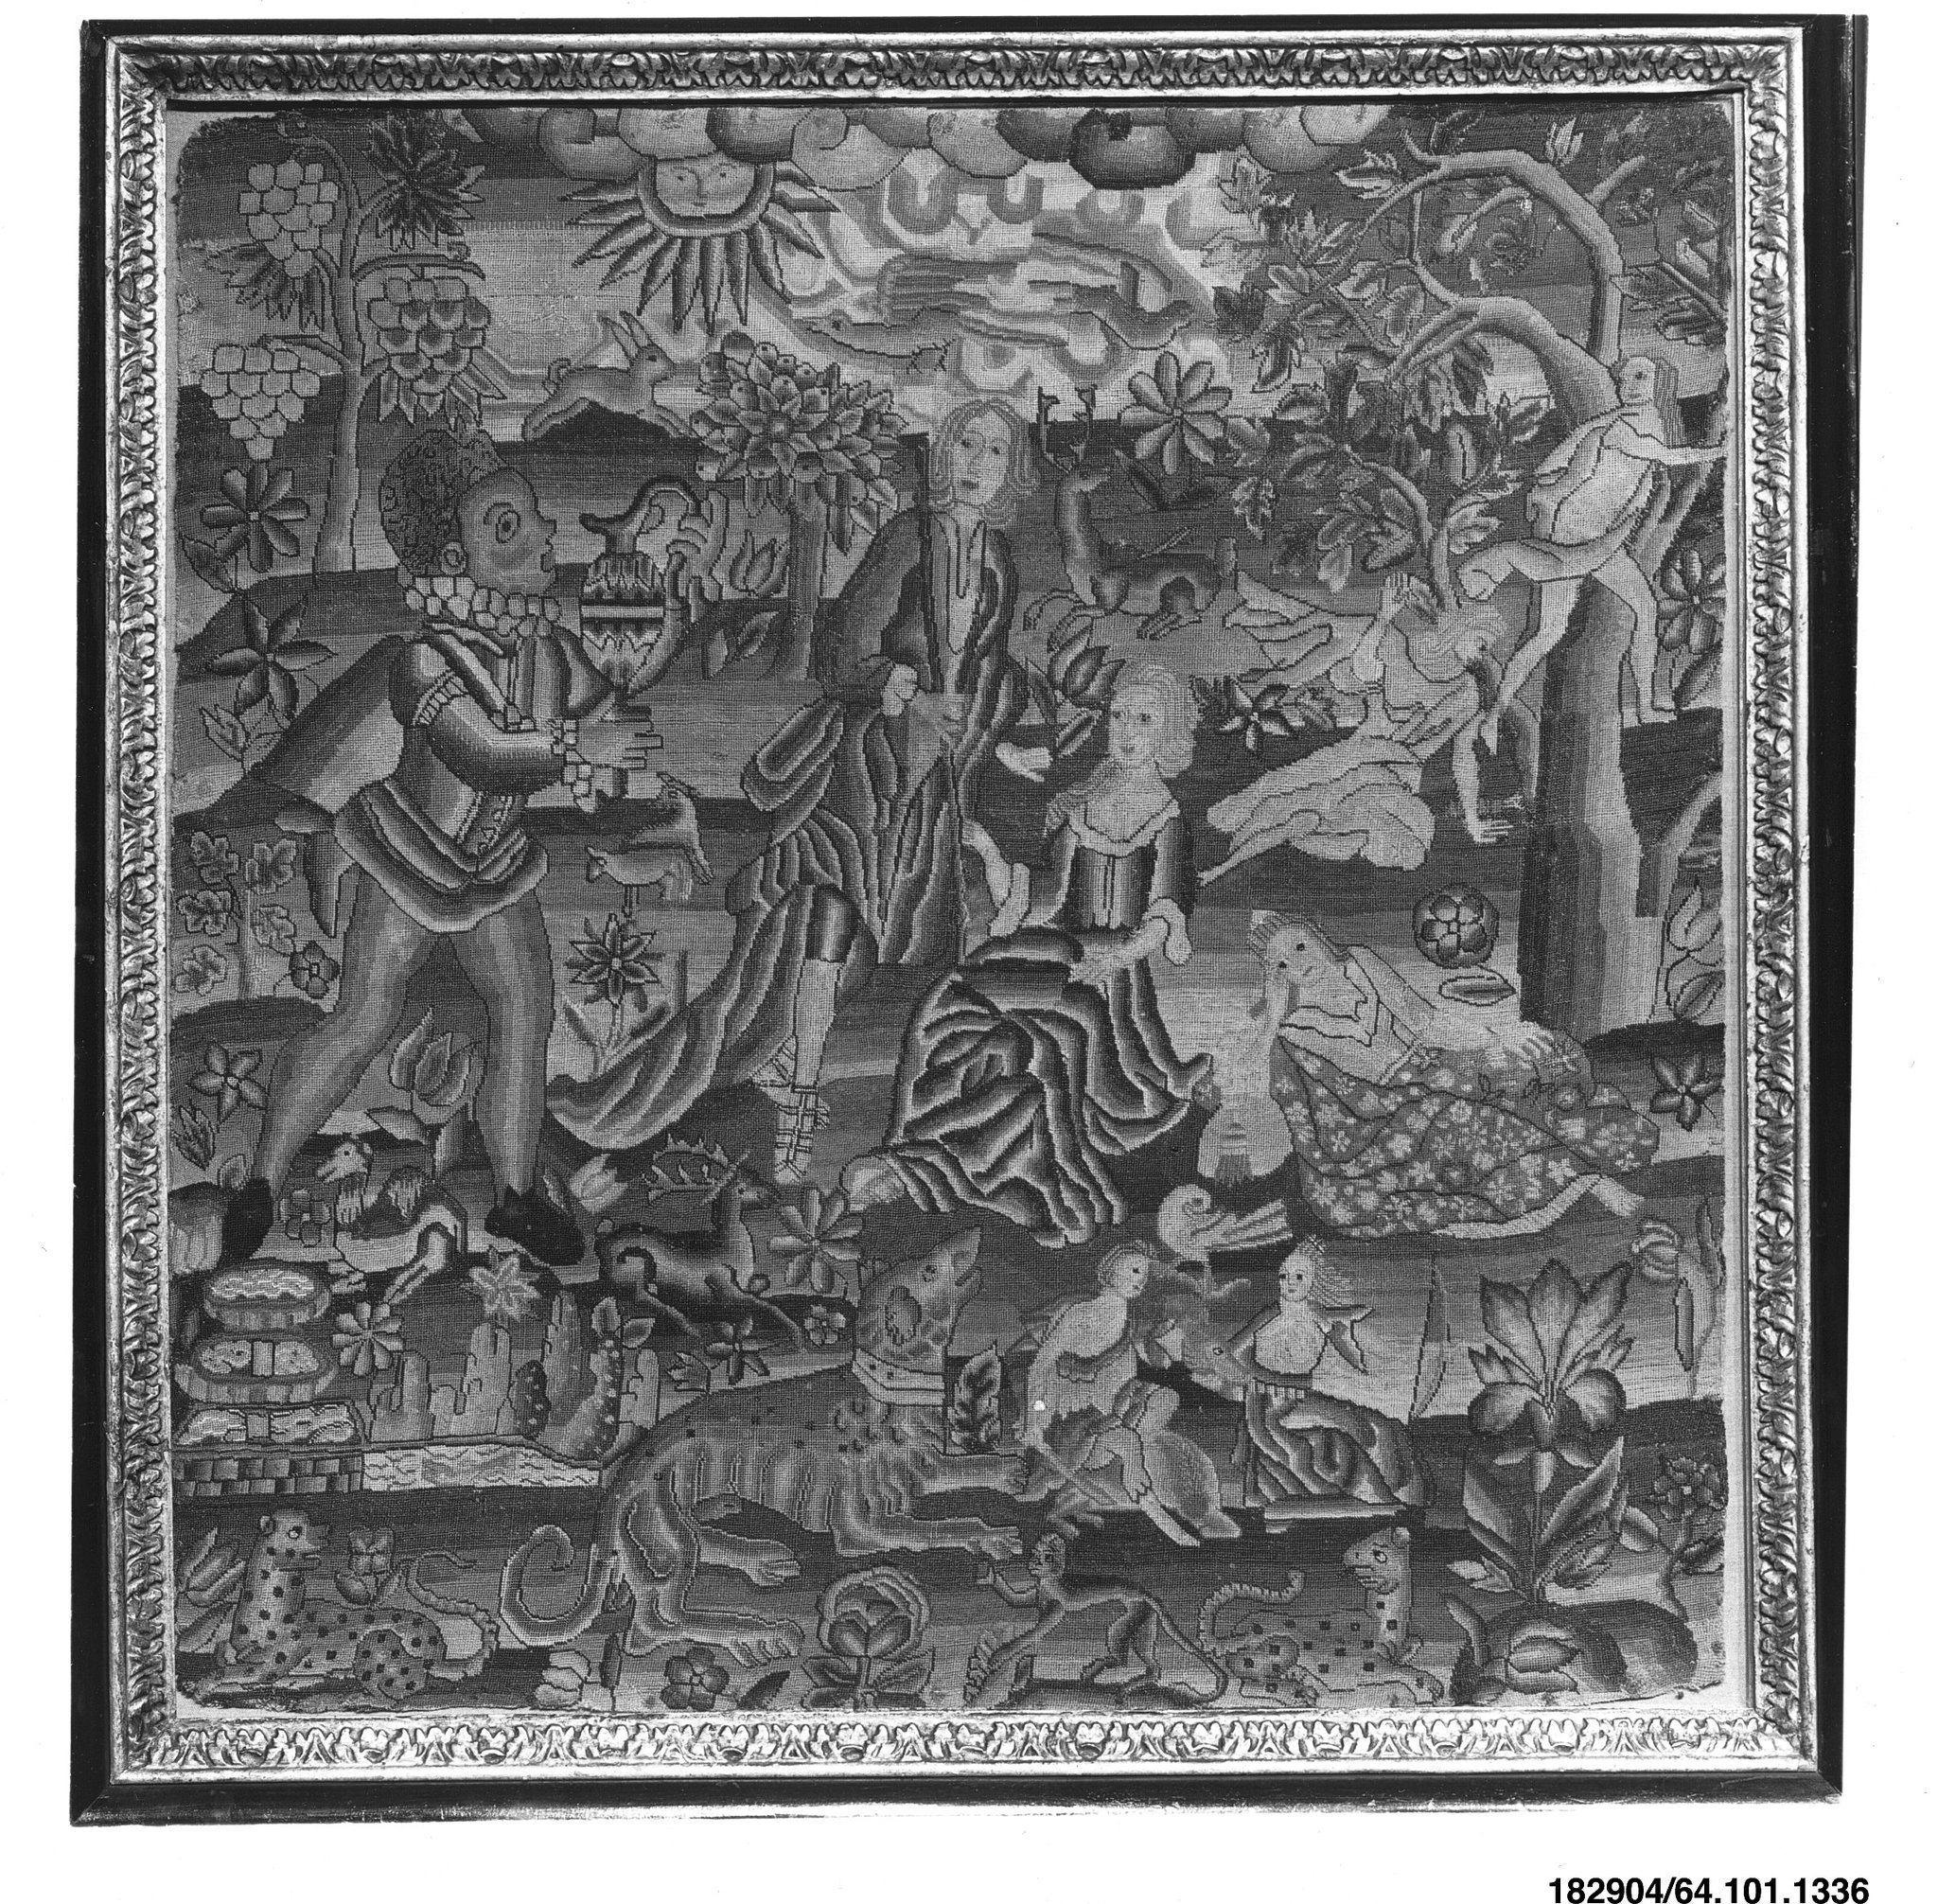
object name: embroidered picture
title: Meleager and Atalanta, Alpheus in pursuit of Arethusa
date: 1651-1675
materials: canvas, silk, wool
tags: men,women,deer,dogs,trees